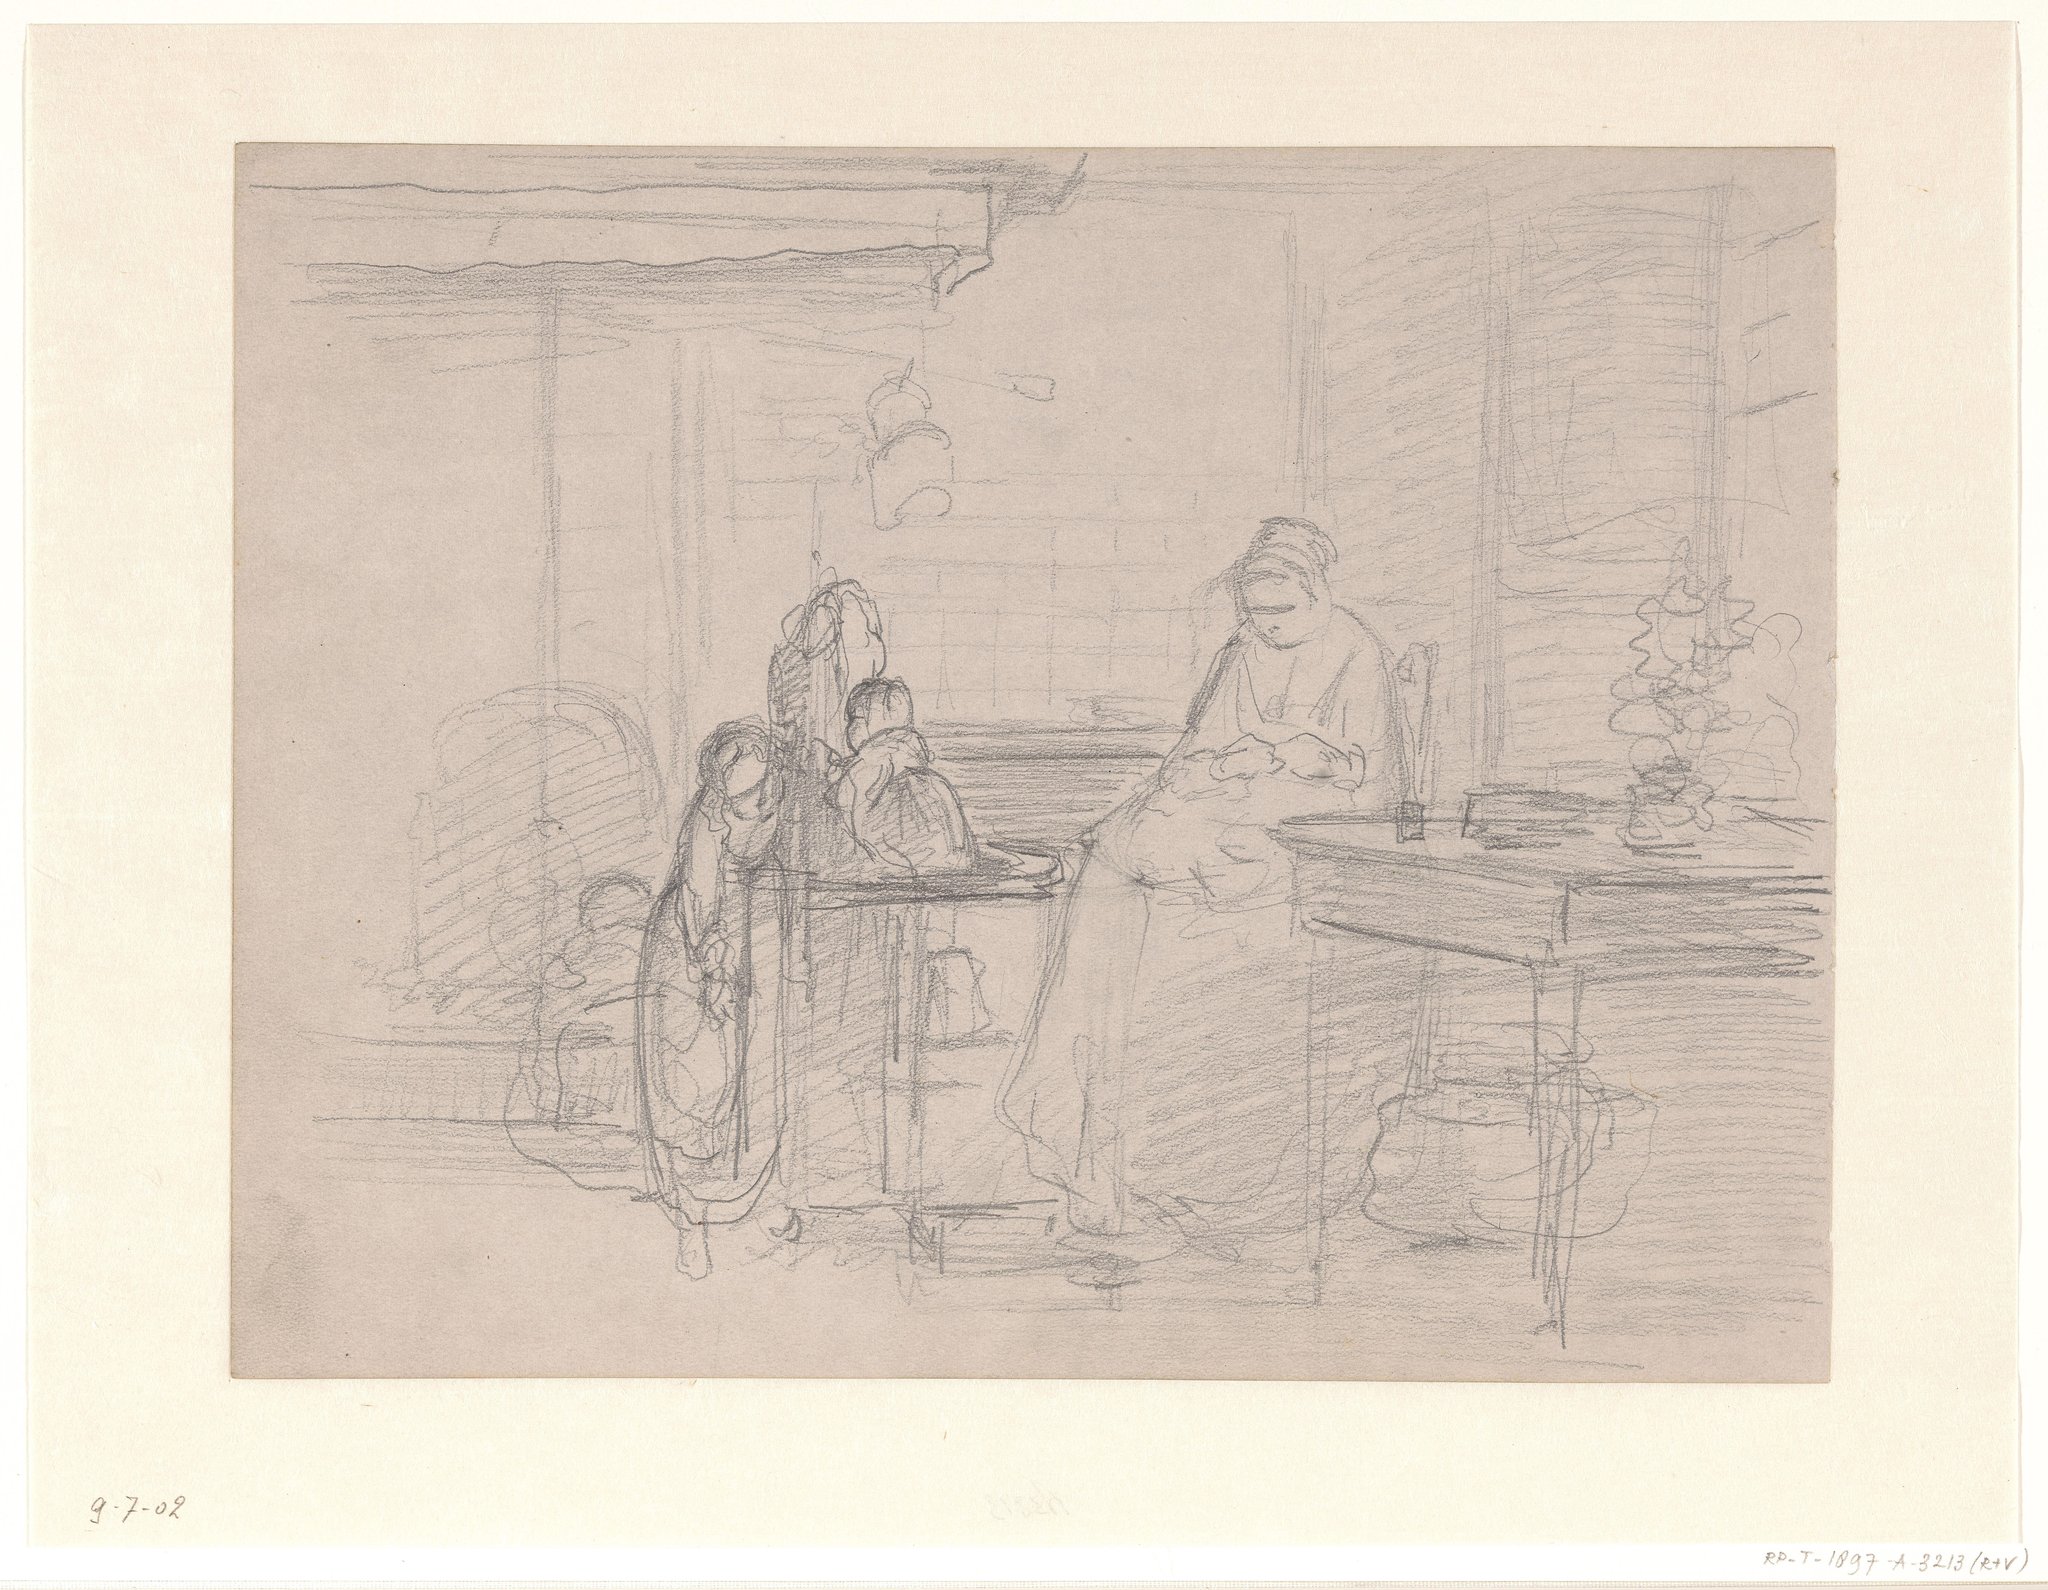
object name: drawing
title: Vrouw met twee kinderen in interieur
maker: hendrik valkenburg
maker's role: draughtsman, painter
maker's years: 1826-1896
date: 1836-1896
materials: paper, pencil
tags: baby-chair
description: Vrouw met twee kinderen, waarvan een in de kinderstoel, in interieur.